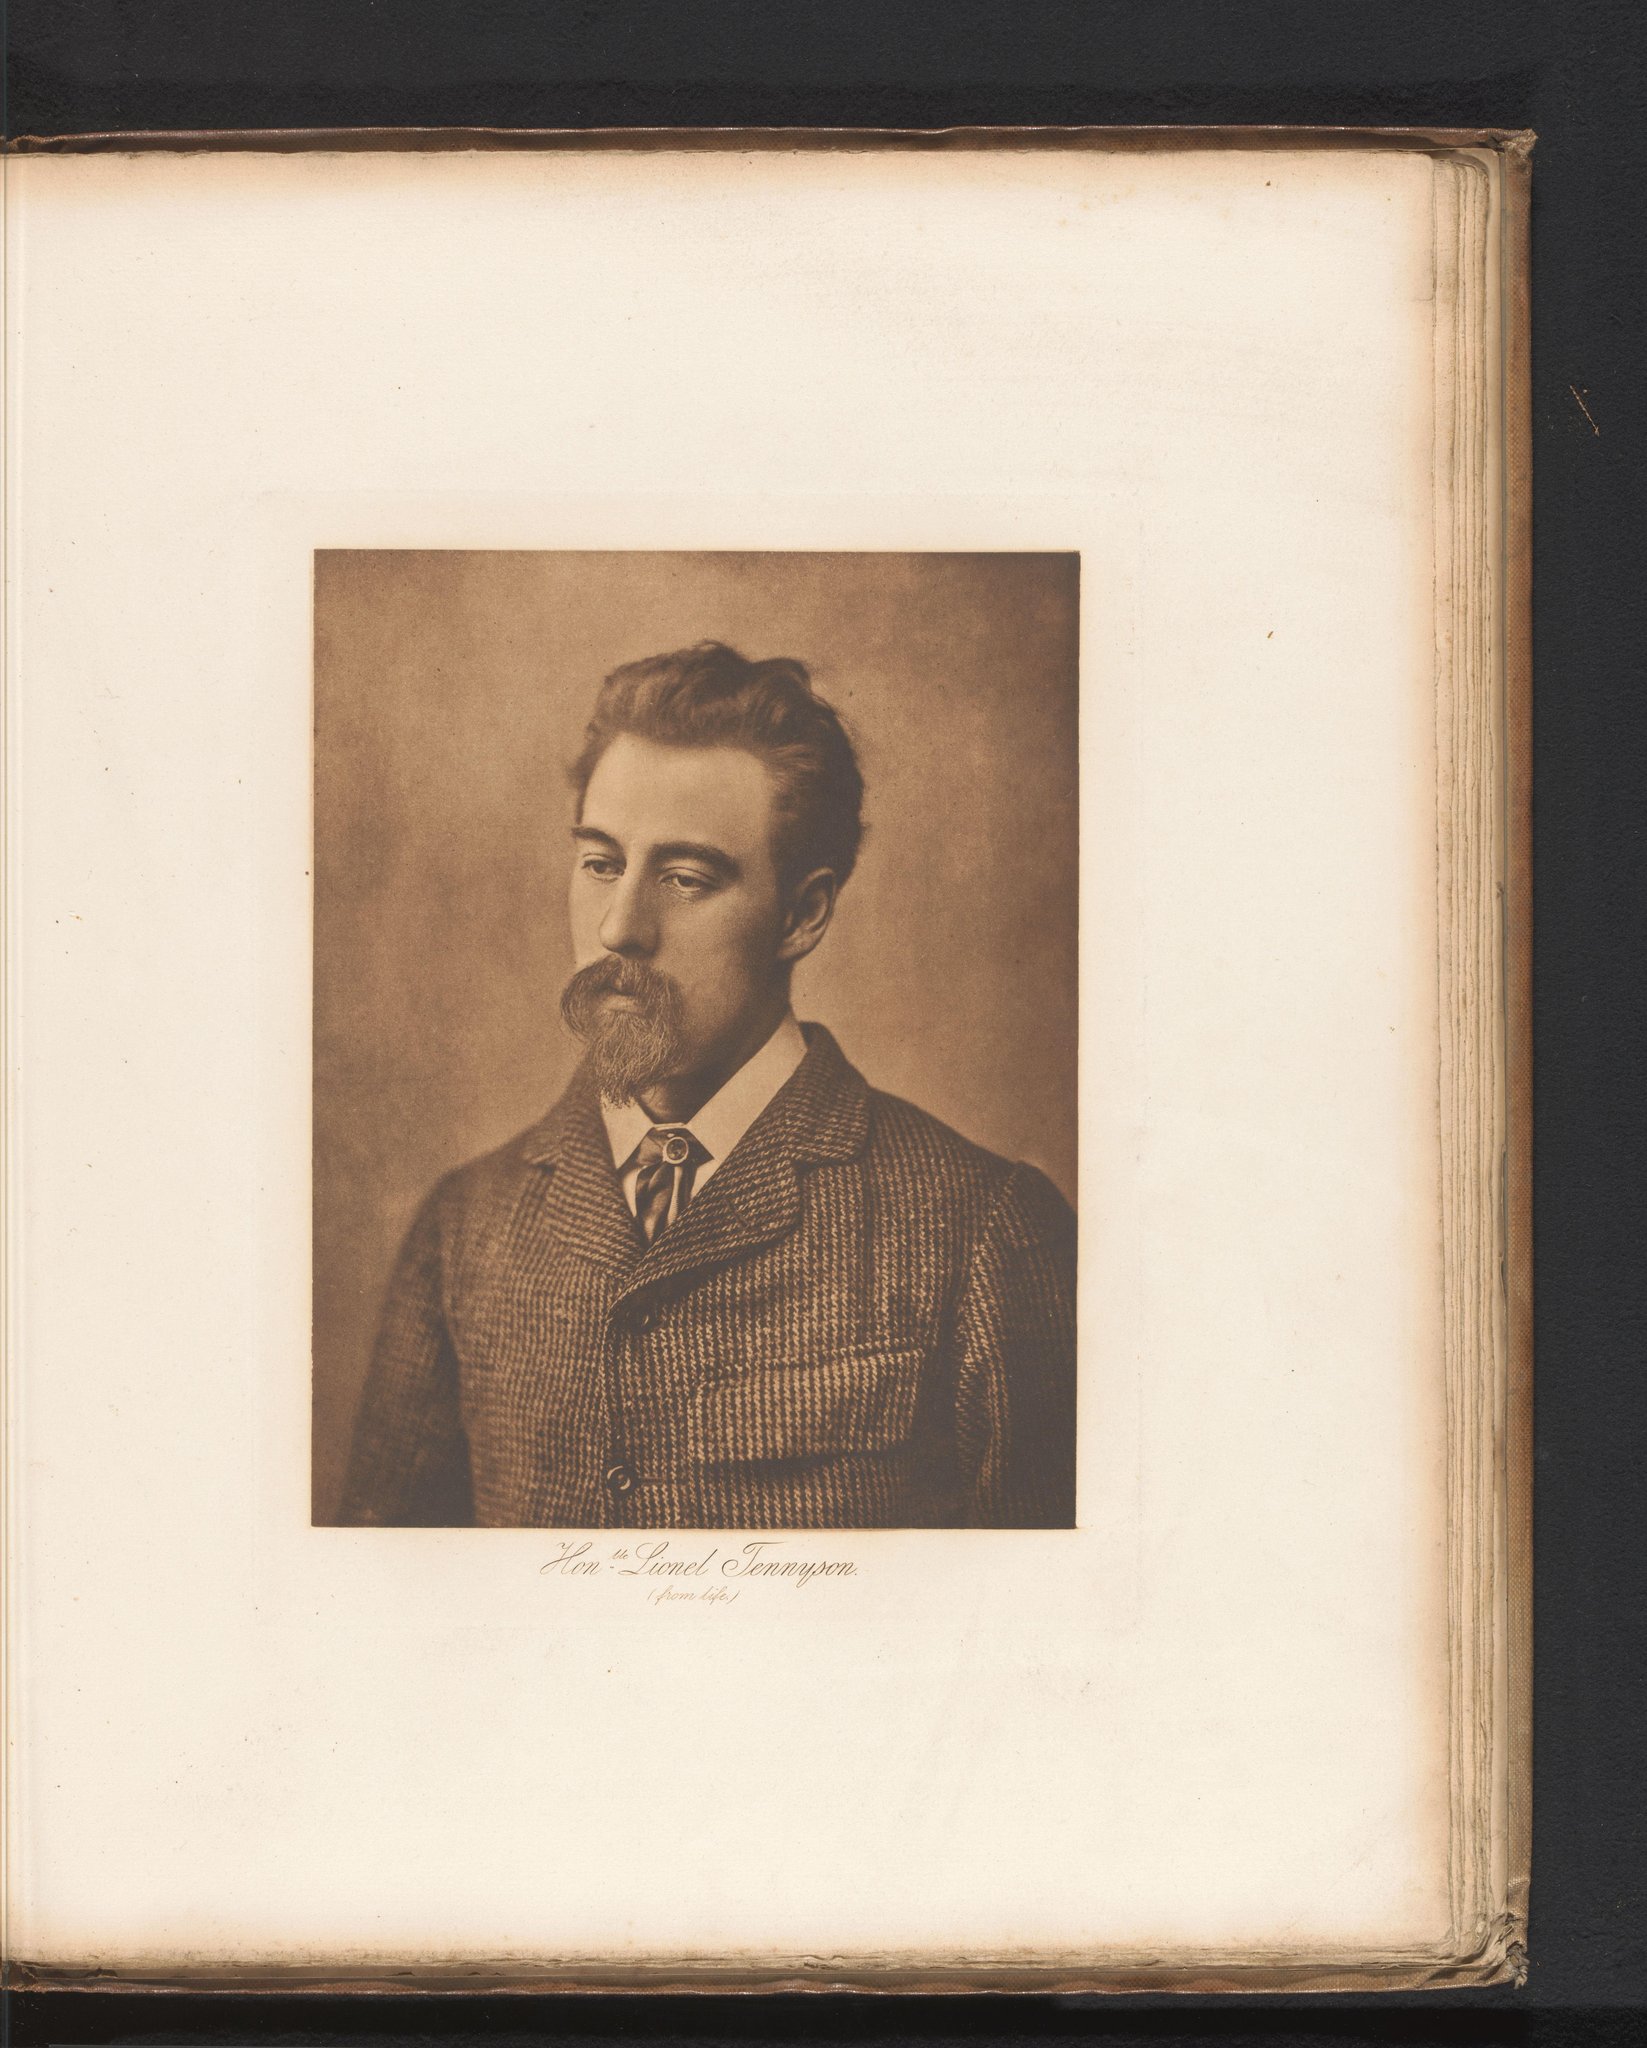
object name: photomechanical print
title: Honble Lionel Tennyson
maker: henry herschel hay cameron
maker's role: fotograaf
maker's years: 1852-1911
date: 1888-1893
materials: paper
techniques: photoaquatint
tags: historical persons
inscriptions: inscription: ‘Honble Lionel Tennyson./ (from life.)’